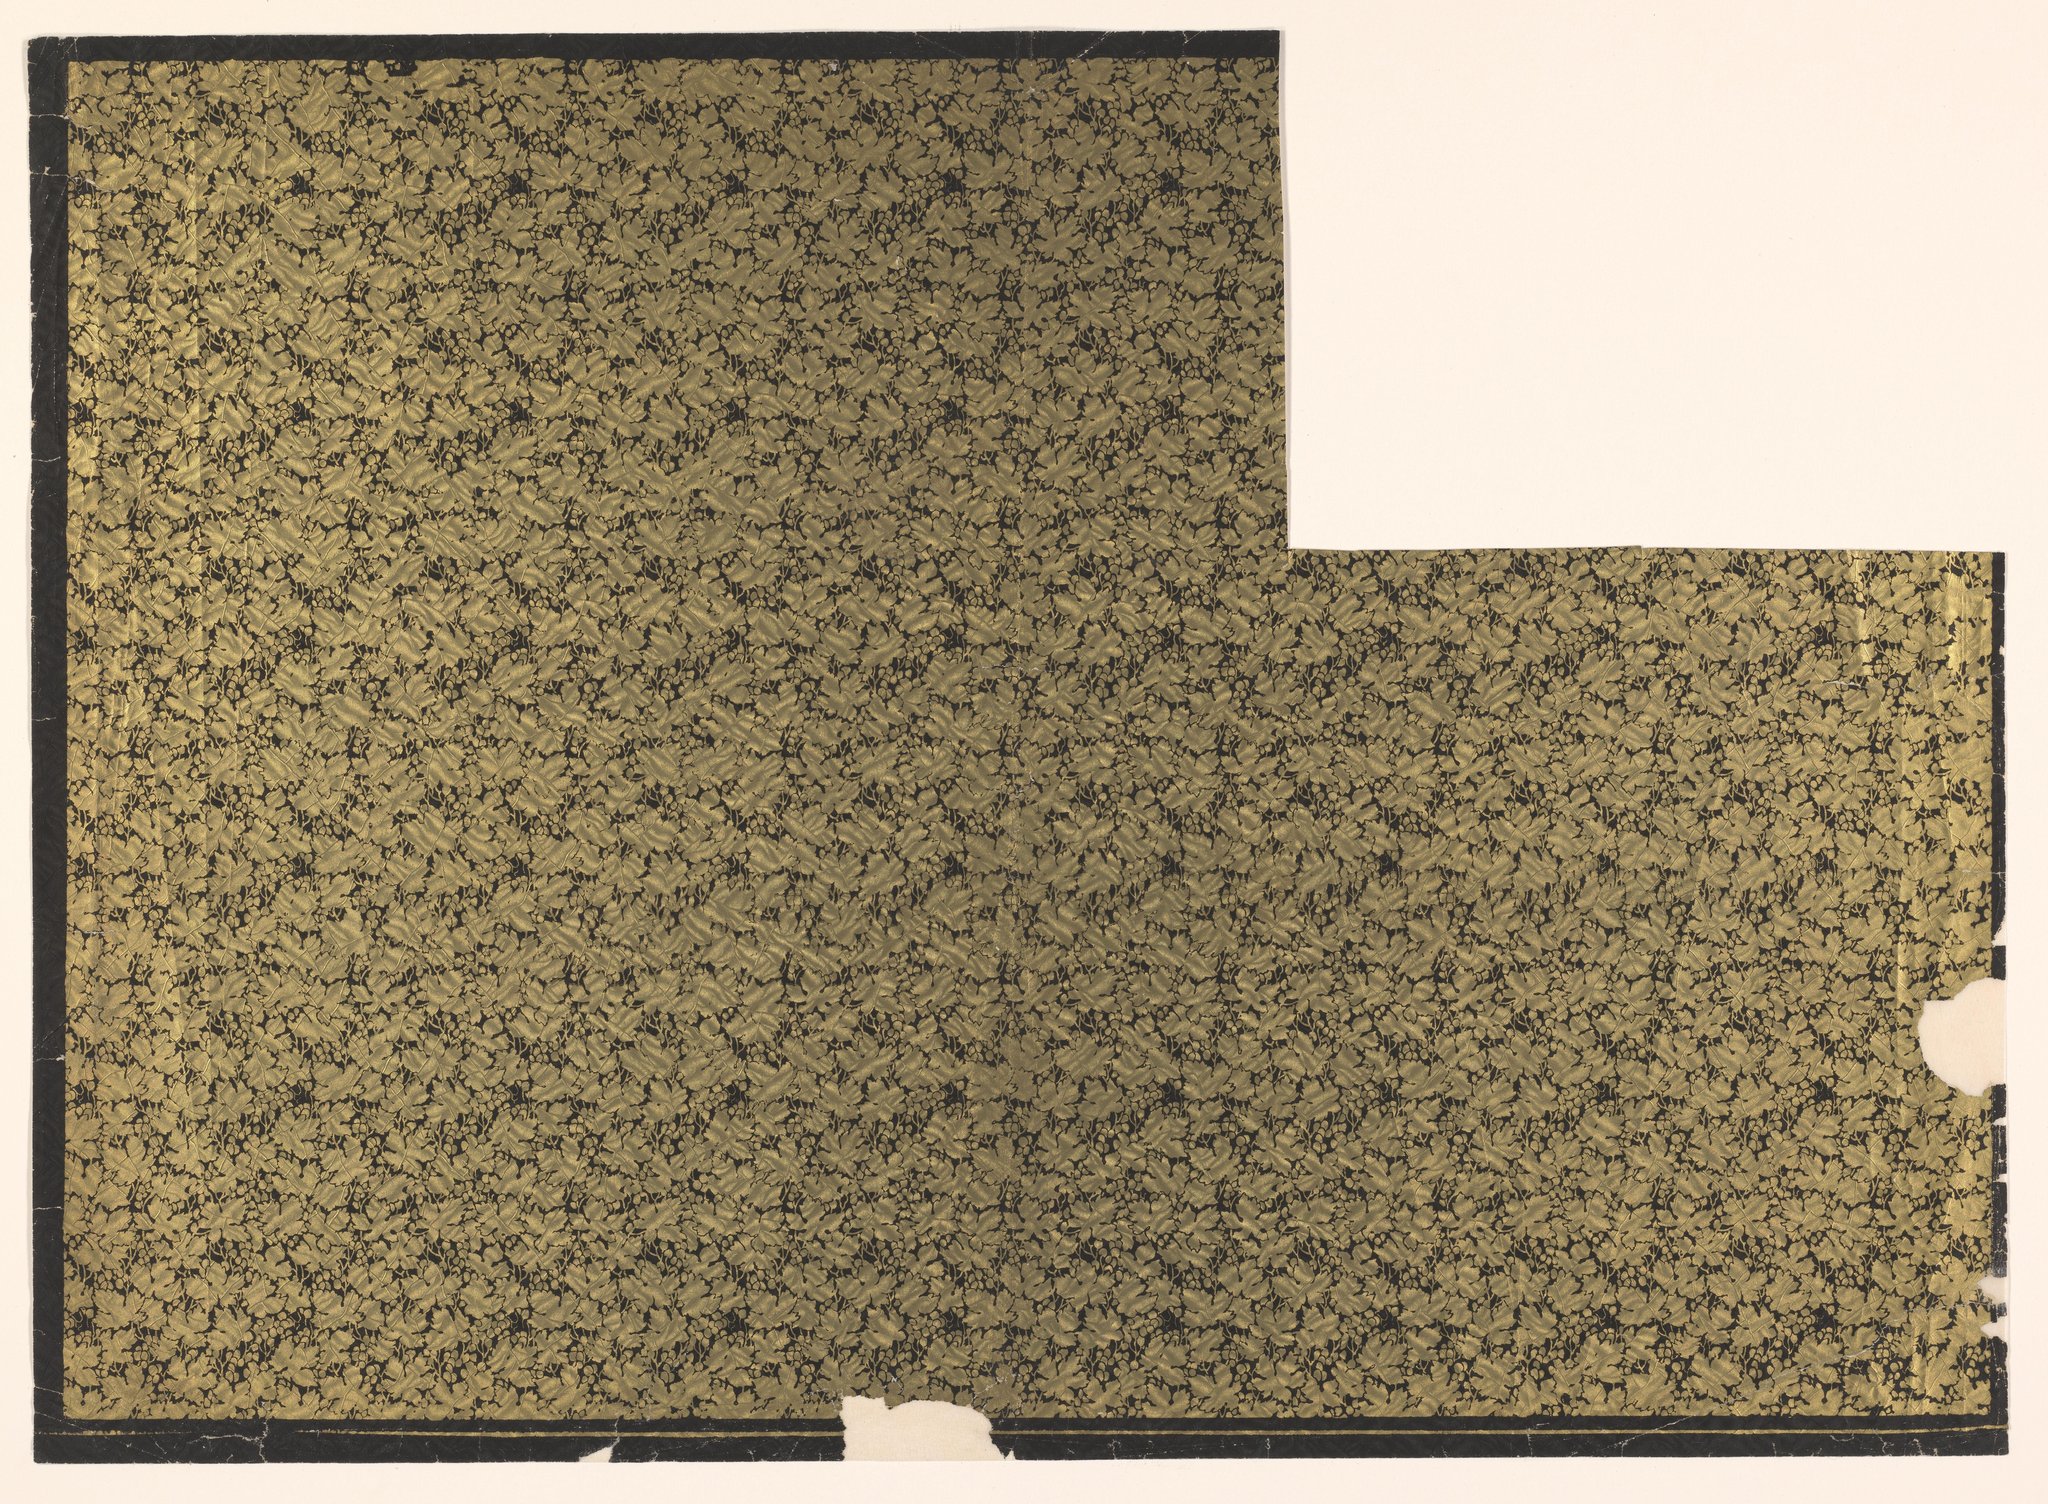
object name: embossed paper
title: Blad met bladeren en vruchten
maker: Anonymous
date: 1850-1950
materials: gold leaf, paper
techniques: printing block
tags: ornament derived from plant forms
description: Blad met een patroon van bladeren en vruchten in goud en zwart. Blad waarvan een hoek is uitgeknipt, en met een los afgescheurd hoekje.